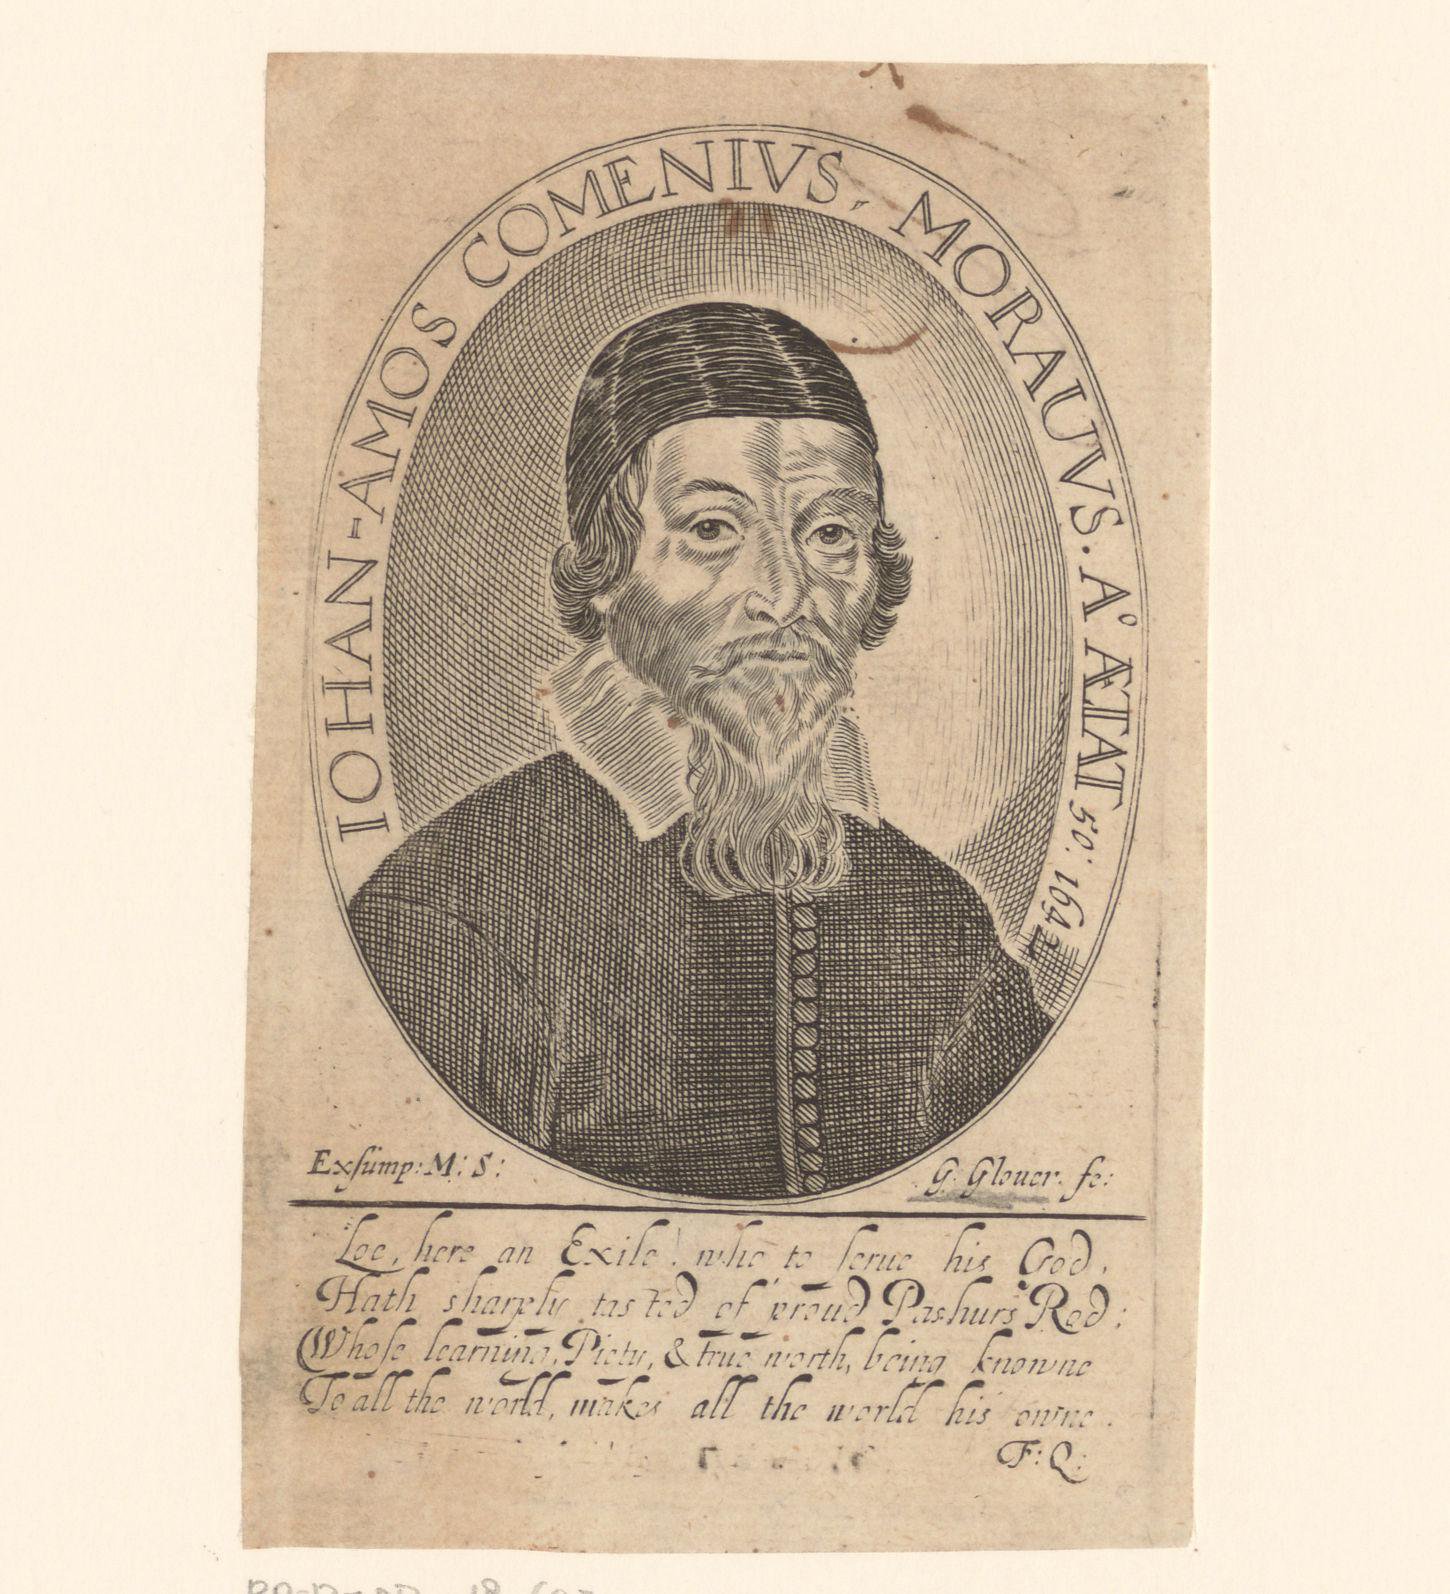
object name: print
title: Portret van Jan Amos Comenius op 50-jarige leeftijd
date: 1642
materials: paper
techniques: engraving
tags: amsterdam, further education (+ portrait of teacher, professor), historical persons, scholar, philosopher (+ portrait of scholar, scientist)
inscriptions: collector's mark: Lugt 2228, collector's mark: Lugt 2228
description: Op de andere staat van deze prent in de collectie van het Rijksmuseum staat de onderste regel tekst in de ondermarge: 'Are to be sould by T.H. and I.C., F.Q'. Deze monogrammen geven de uitgevers en de schrijver aan.